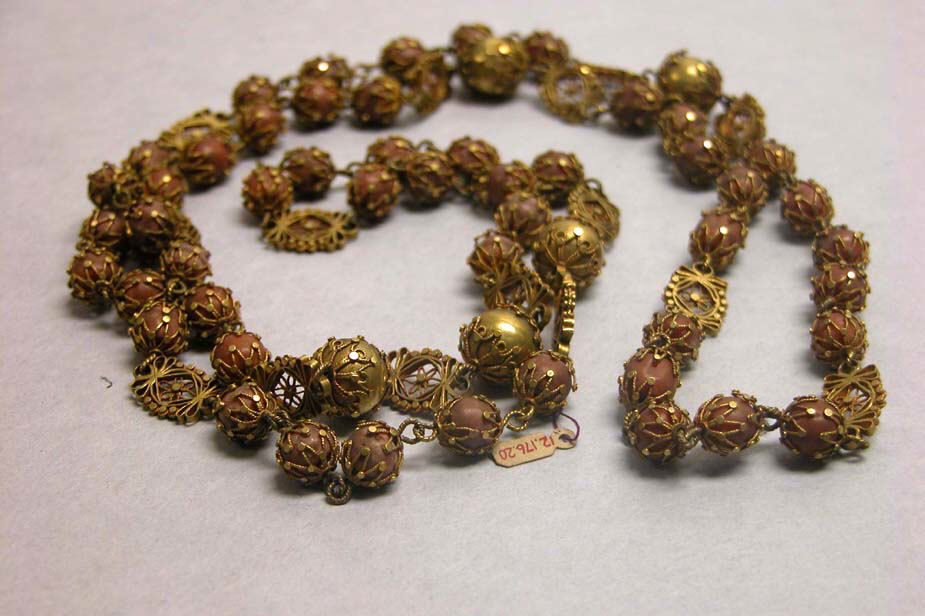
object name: necklace or rosary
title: Necklace or Rosary (?)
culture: filipino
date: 1734-1900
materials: coral, gold